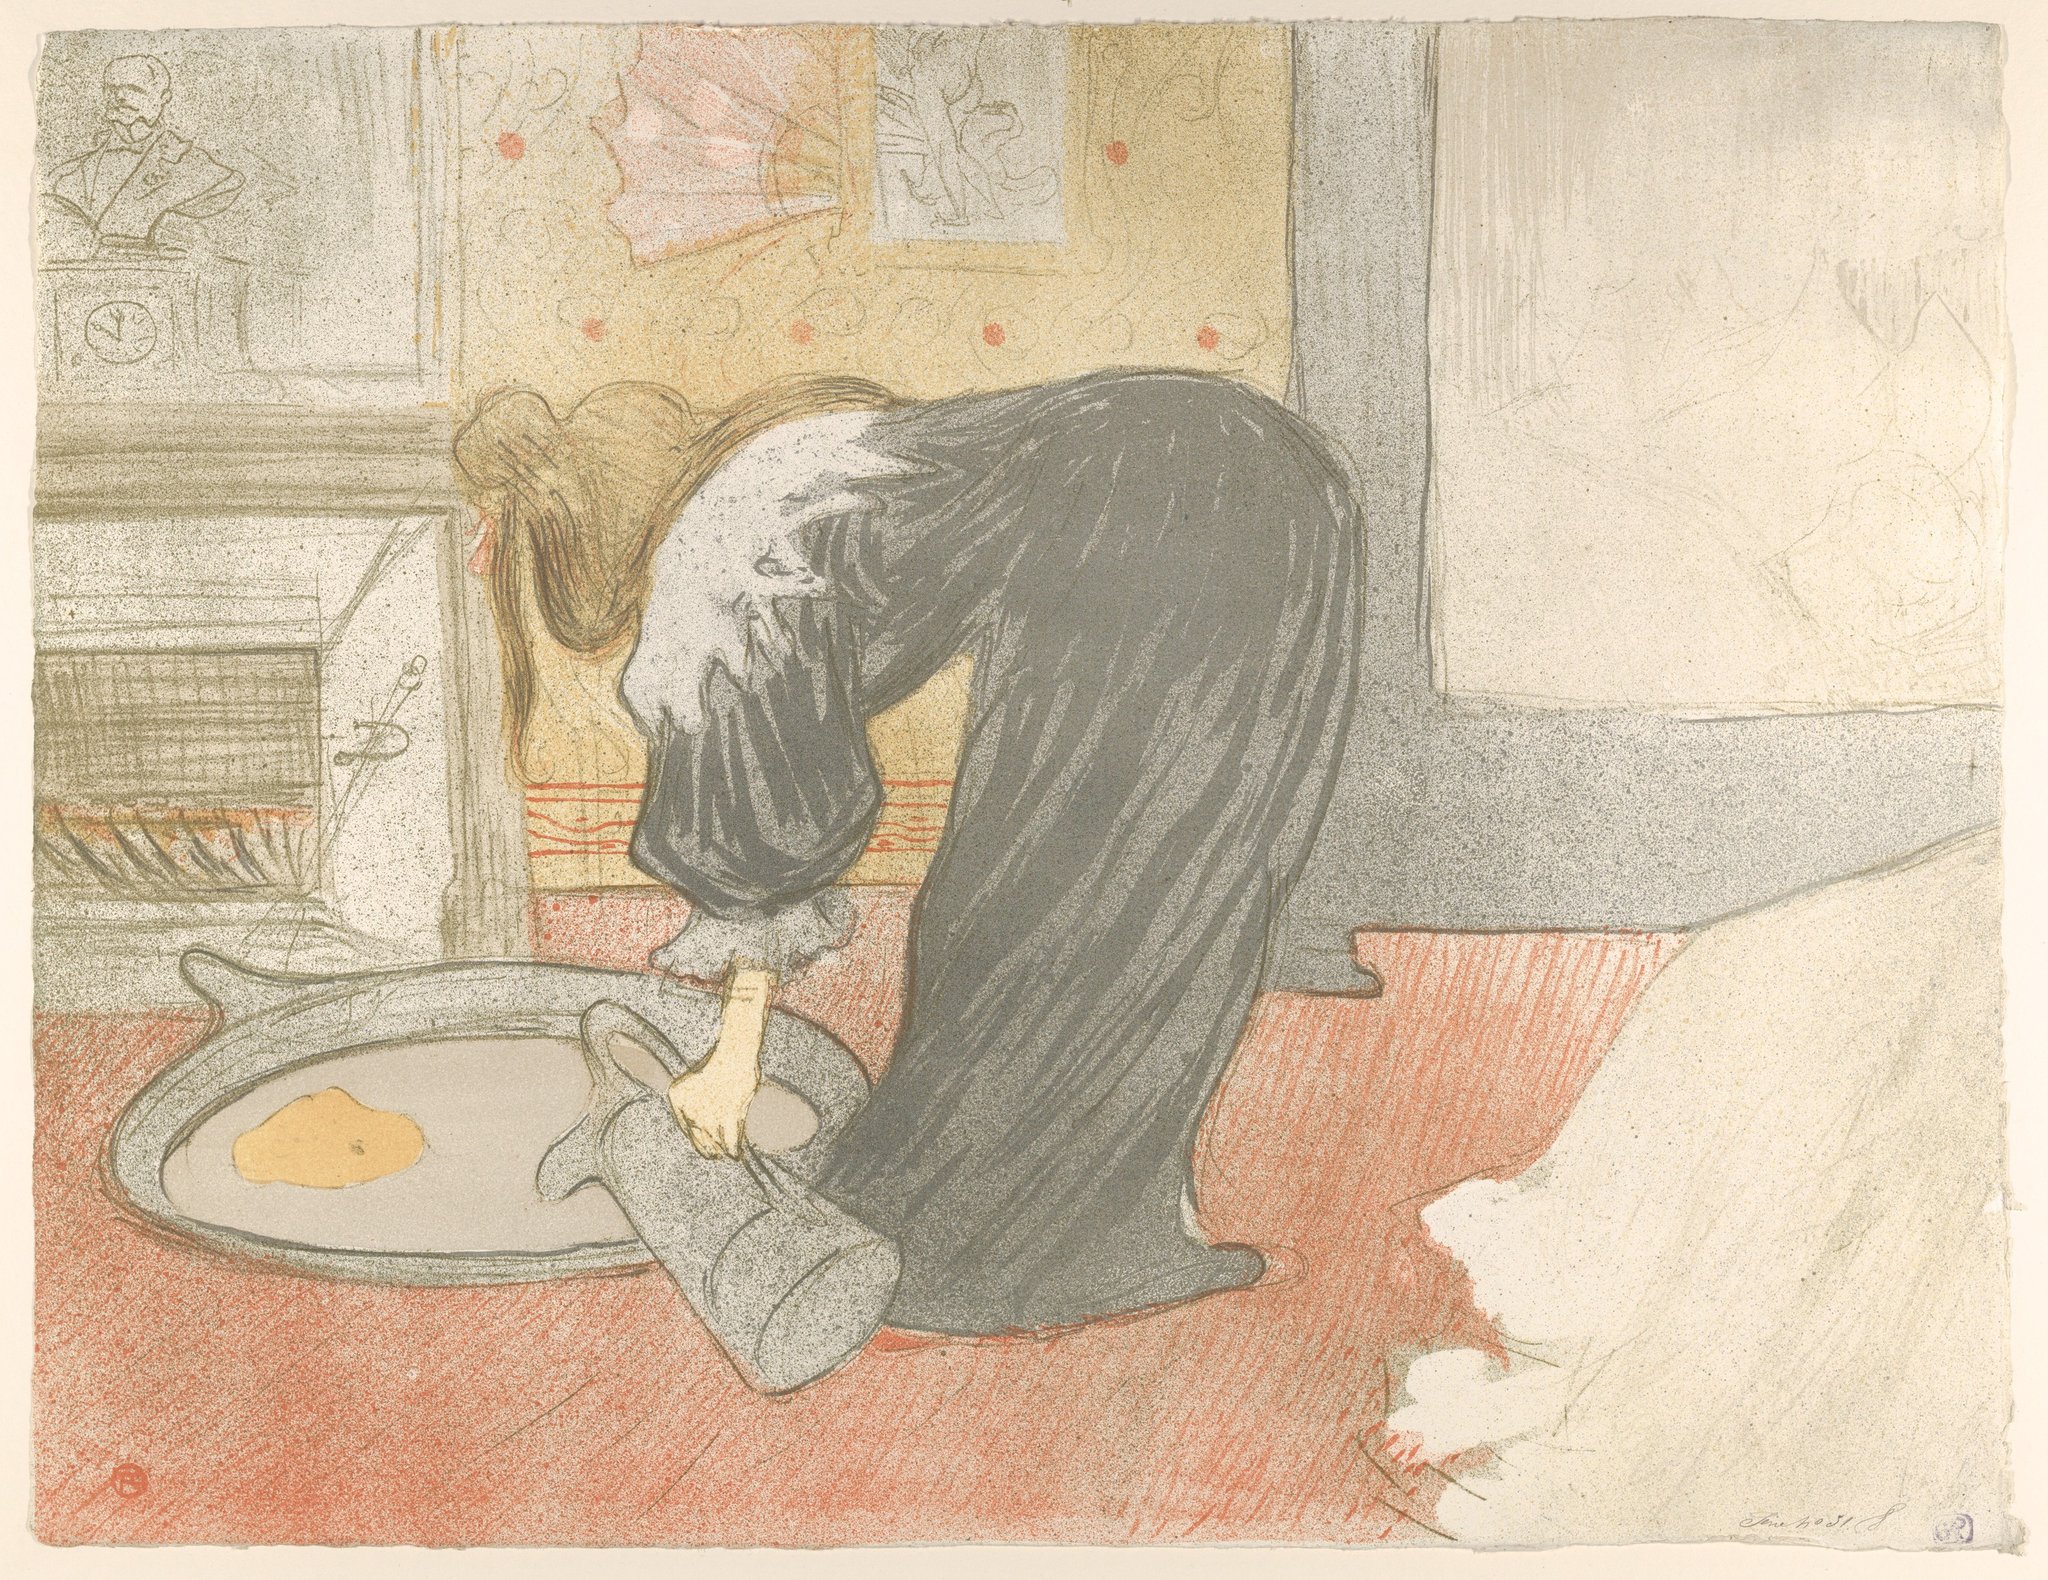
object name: print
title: Filling a Tub, from "Elles"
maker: henri de toulouse-lautrec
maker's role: artist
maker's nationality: french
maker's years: 1864-1901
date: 1896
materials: crayon, paper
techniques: brush, lithograph, printing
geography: france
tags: women,genre scene